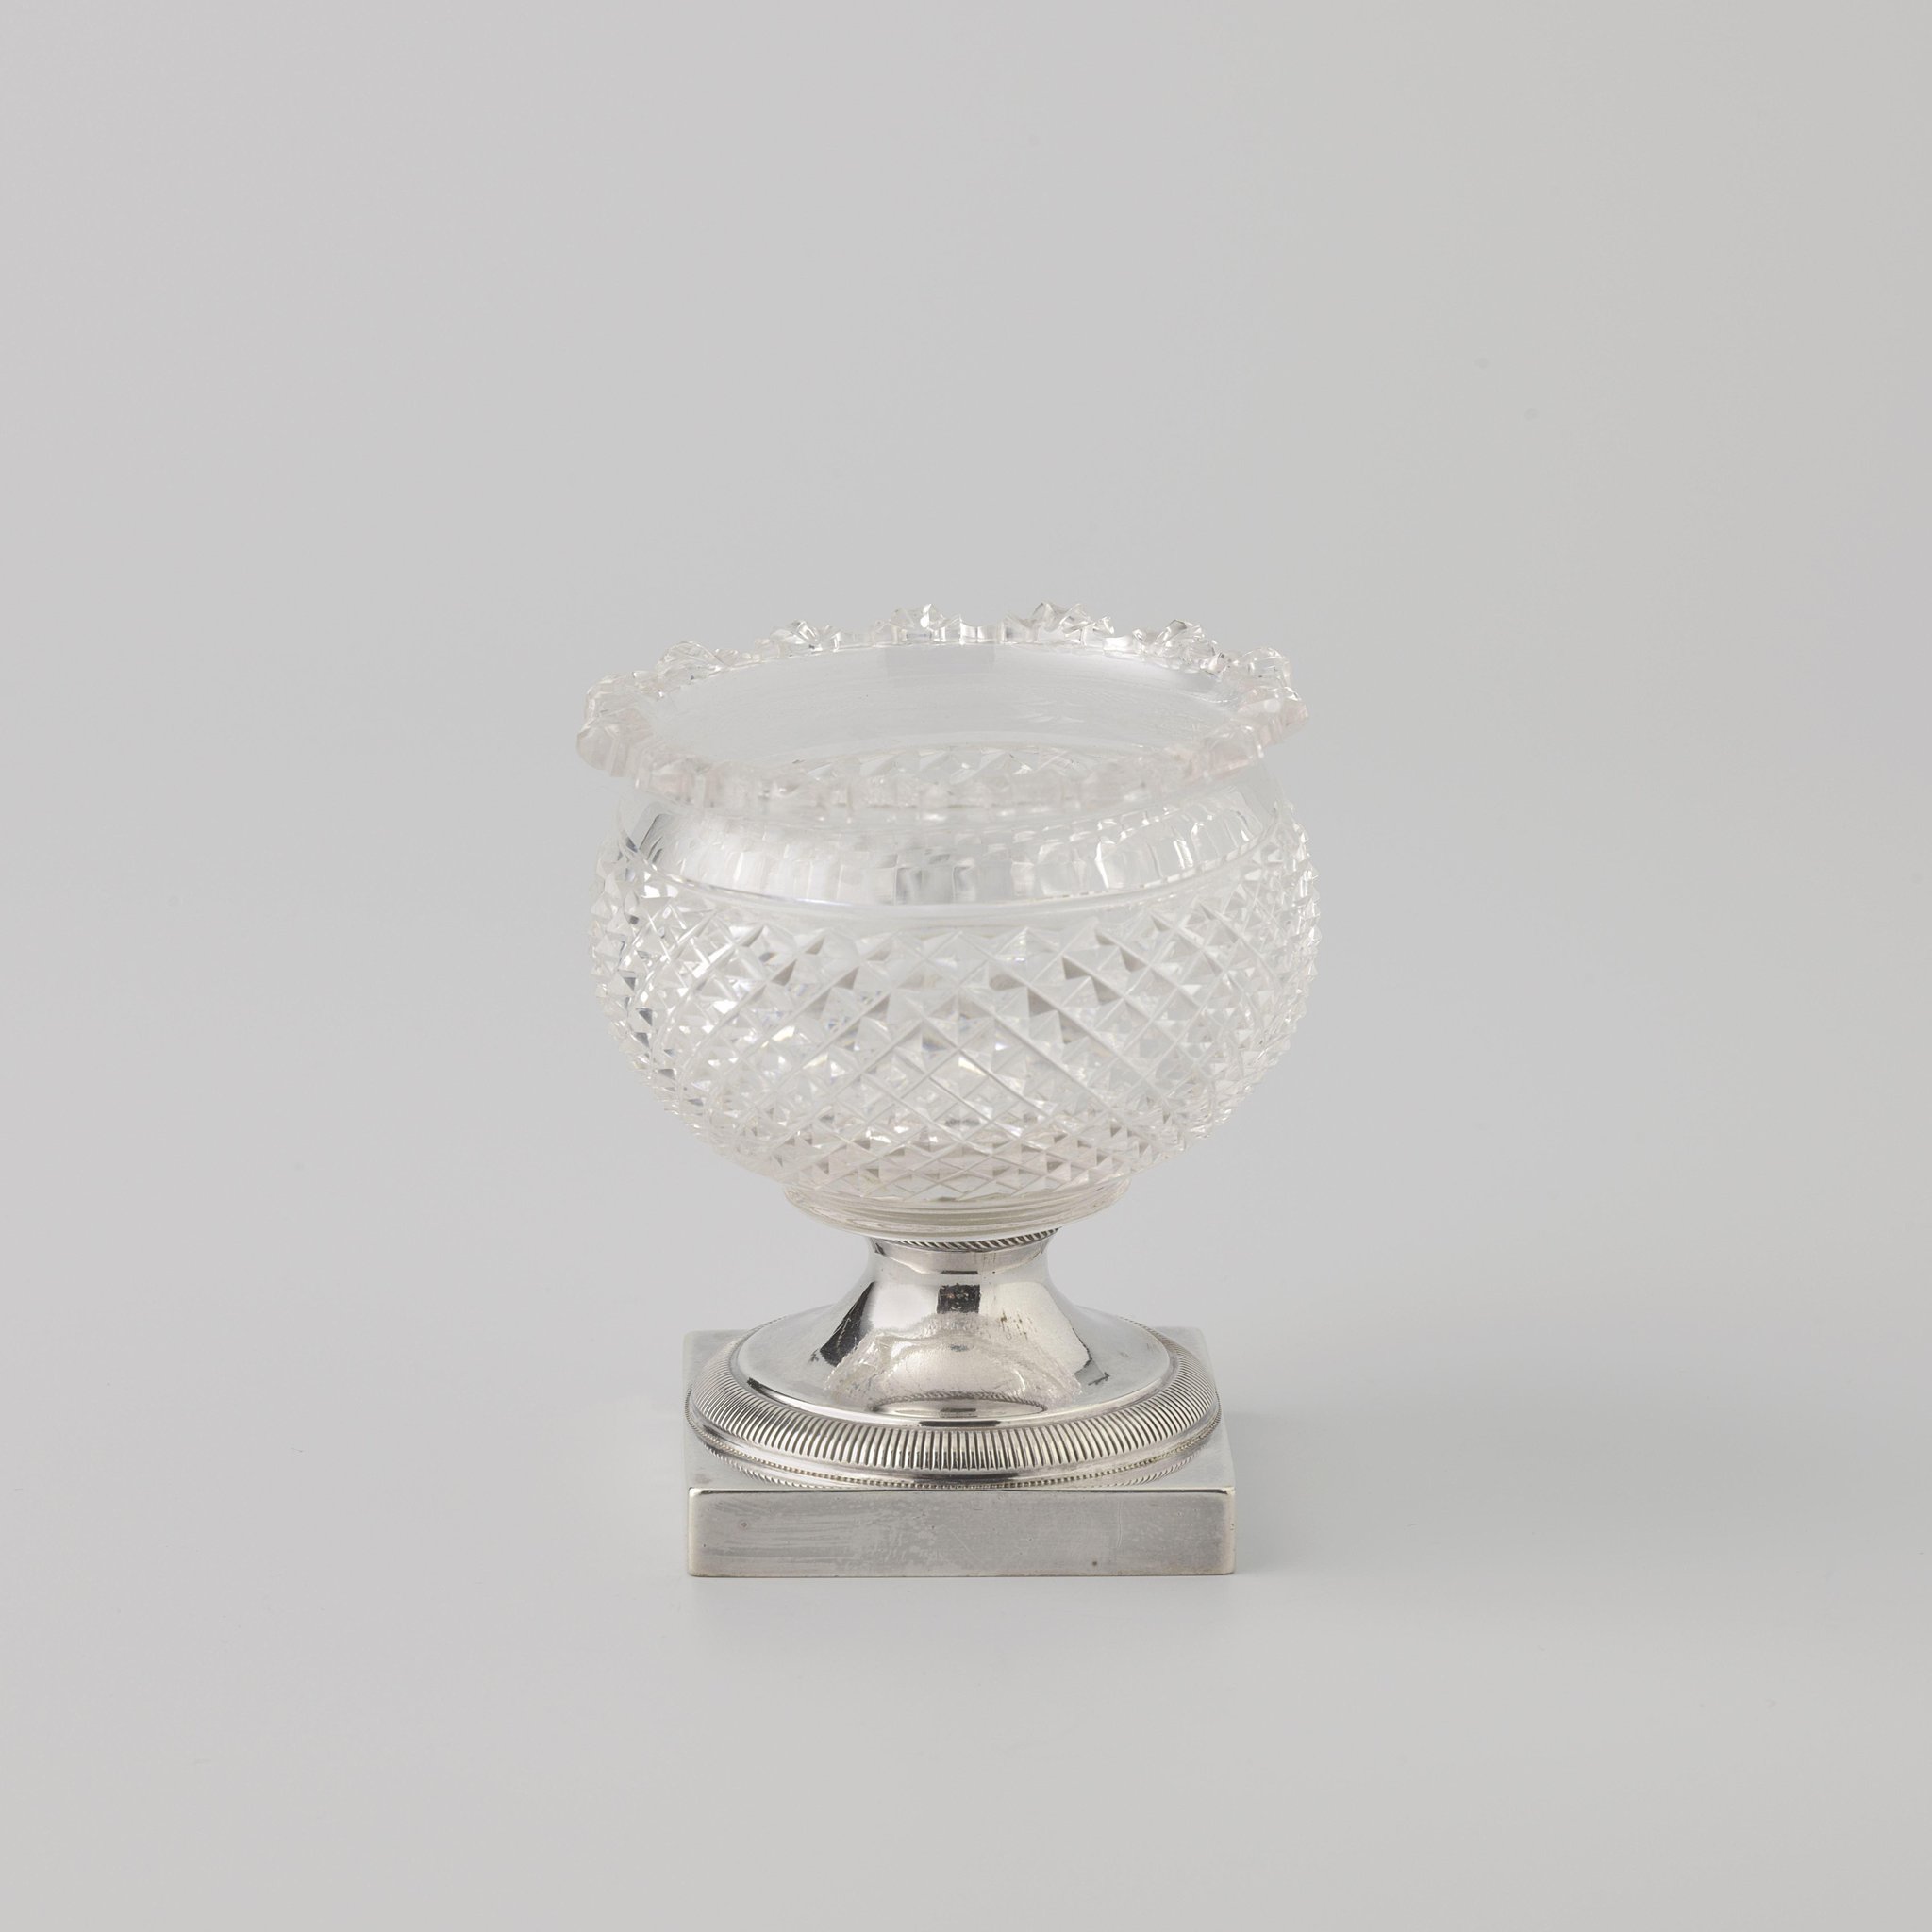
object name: salt condiment vessel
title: Zoutvat bolvormig op vierkante voet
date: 1830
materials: glass, gypsum, silver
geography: amsterdam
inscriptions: assay office mark, maker's mark, date letter: ‘V’, alloy mark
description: De vier bolvormige vaatjes van kleurloos glas, met uitgebogen rand, rusten elk op een ronde, gewelfde, zich verjongende voet op een vierkant basement. Aan de onderzijde van de voet loopt een geribde band en aan de bovenzijde een kabelrand. Het vat is geslepen in een motief van diamanten, de geschulpte rand in facetten. De voet is met gips opgevuld.